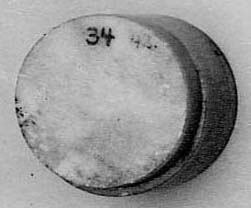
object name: fragment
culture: burmese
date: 1902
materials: jade